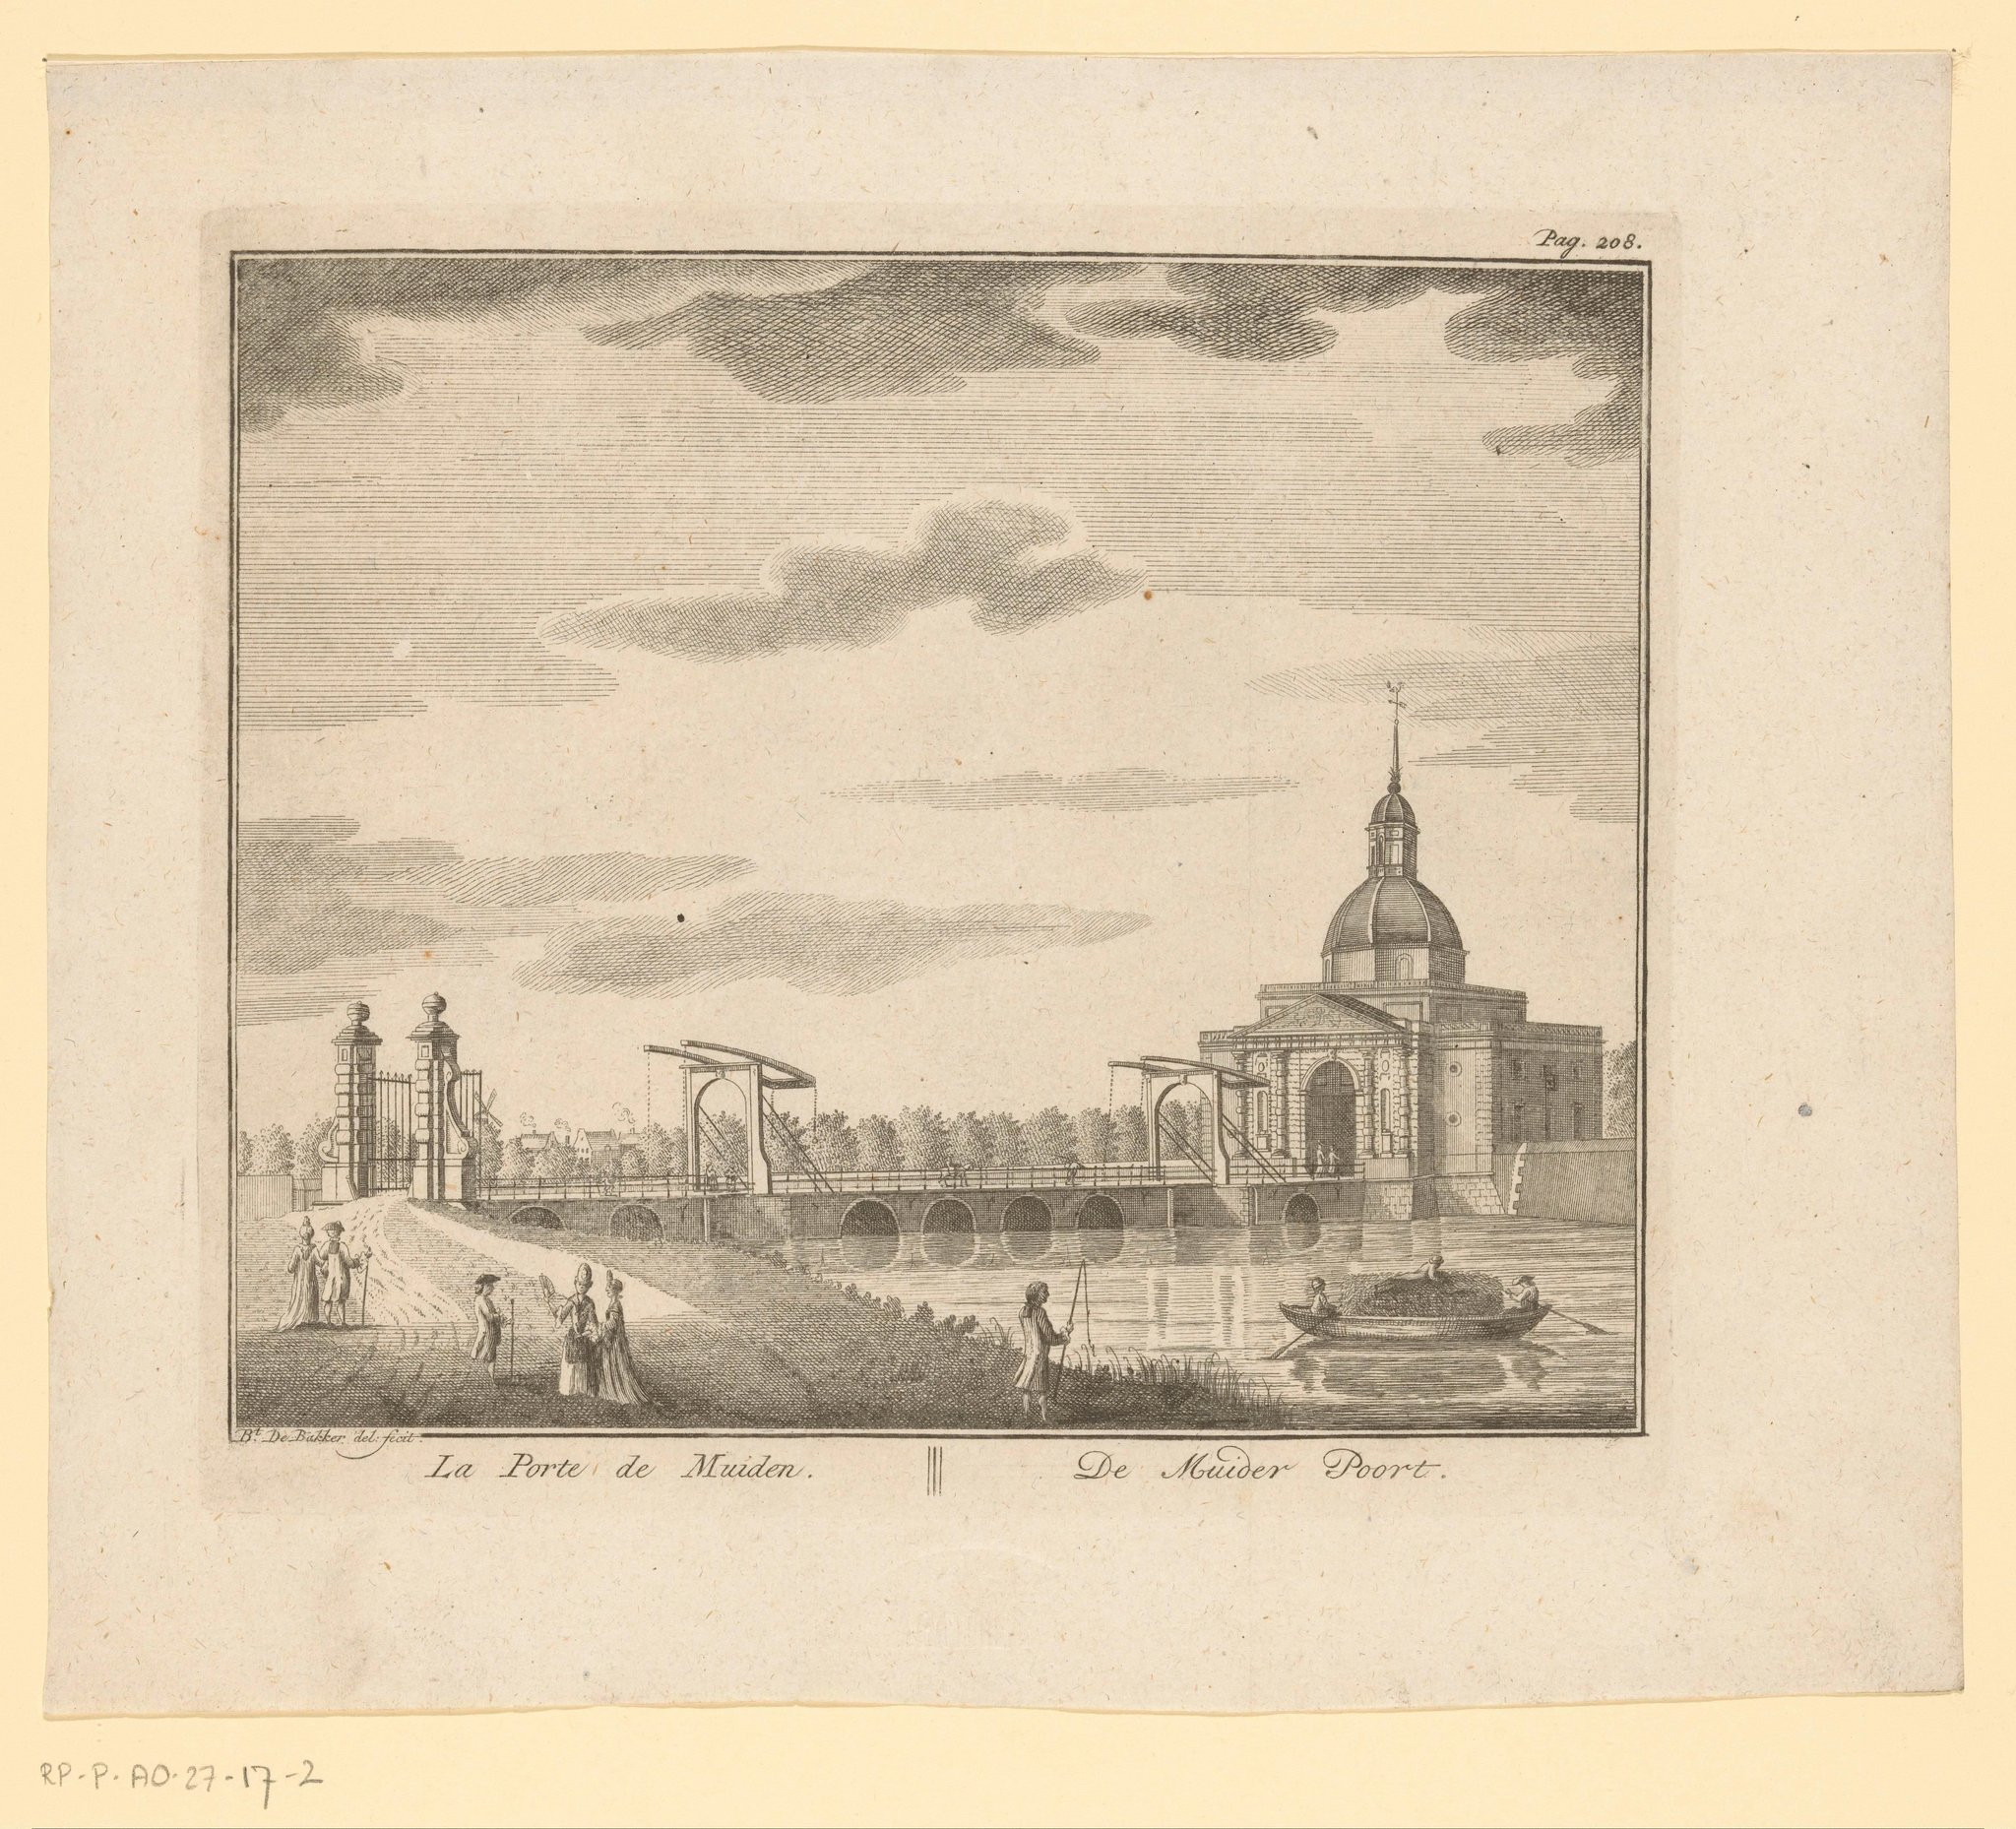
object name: print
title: Gezicht op de Tweede Muiderpoort te Amsterdam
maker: barent de bakker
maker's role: print maker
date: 1772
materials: paper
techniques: engraving, etching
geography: amsterdam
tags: bridge, city-gate, canal (+ landscape with figures, staffage)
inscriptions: check stamp: ‘Archief Ministerie van Oorlog Afdeeling Genie’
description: Gezicht op de in 1770 gebouwde Tweede Muiderpoort en de bijhorende brug te Amsterdam. Op de brug en op de weg wandelen verschillende figuren. Gebouwd ter vervaging van de in 1769 verzakte poort. Onder de voorstelling de titel in het Nederlands en Frans.